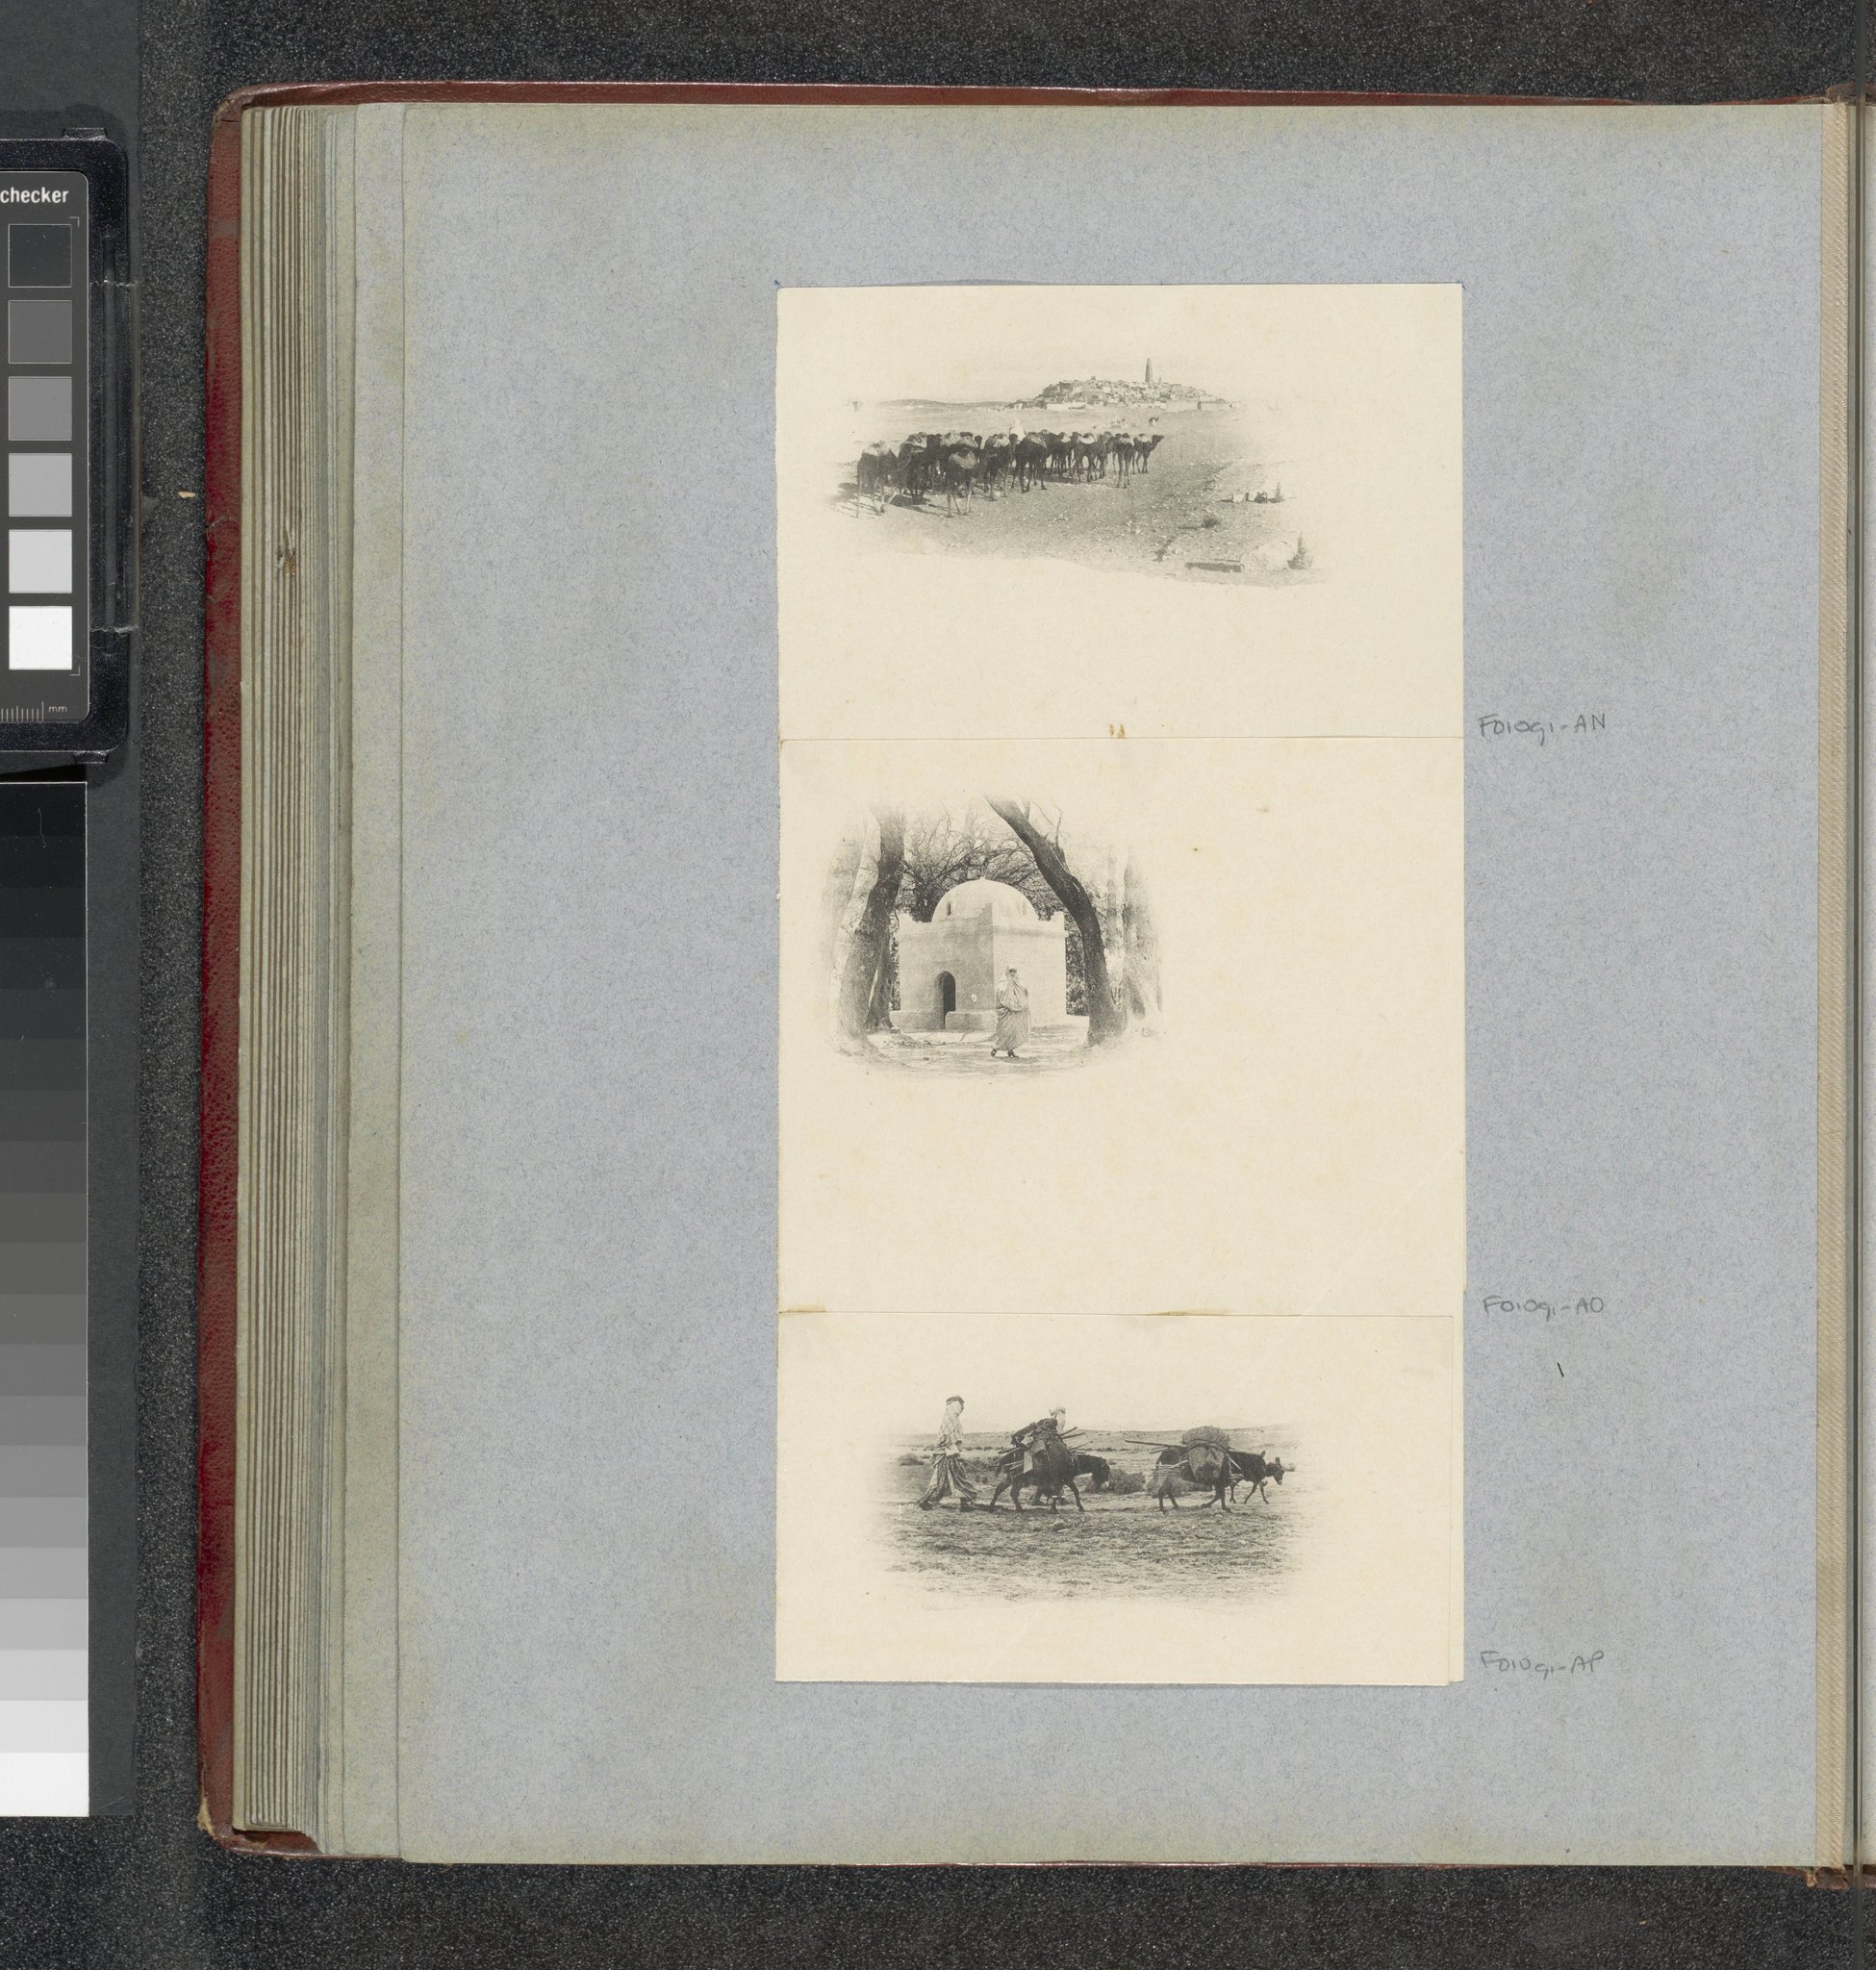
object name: album leaf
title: Gesluierde vrouw bij een gebouw tussen bomen in Tunesië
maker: Anonymous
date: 1880-1900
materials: paper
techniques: photograph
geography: tunisia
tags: adult woman, head-gear (with name)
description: Onderdeel van Reisalbum met foto's van bezienswaardigheden in Tunis en Tunesië.